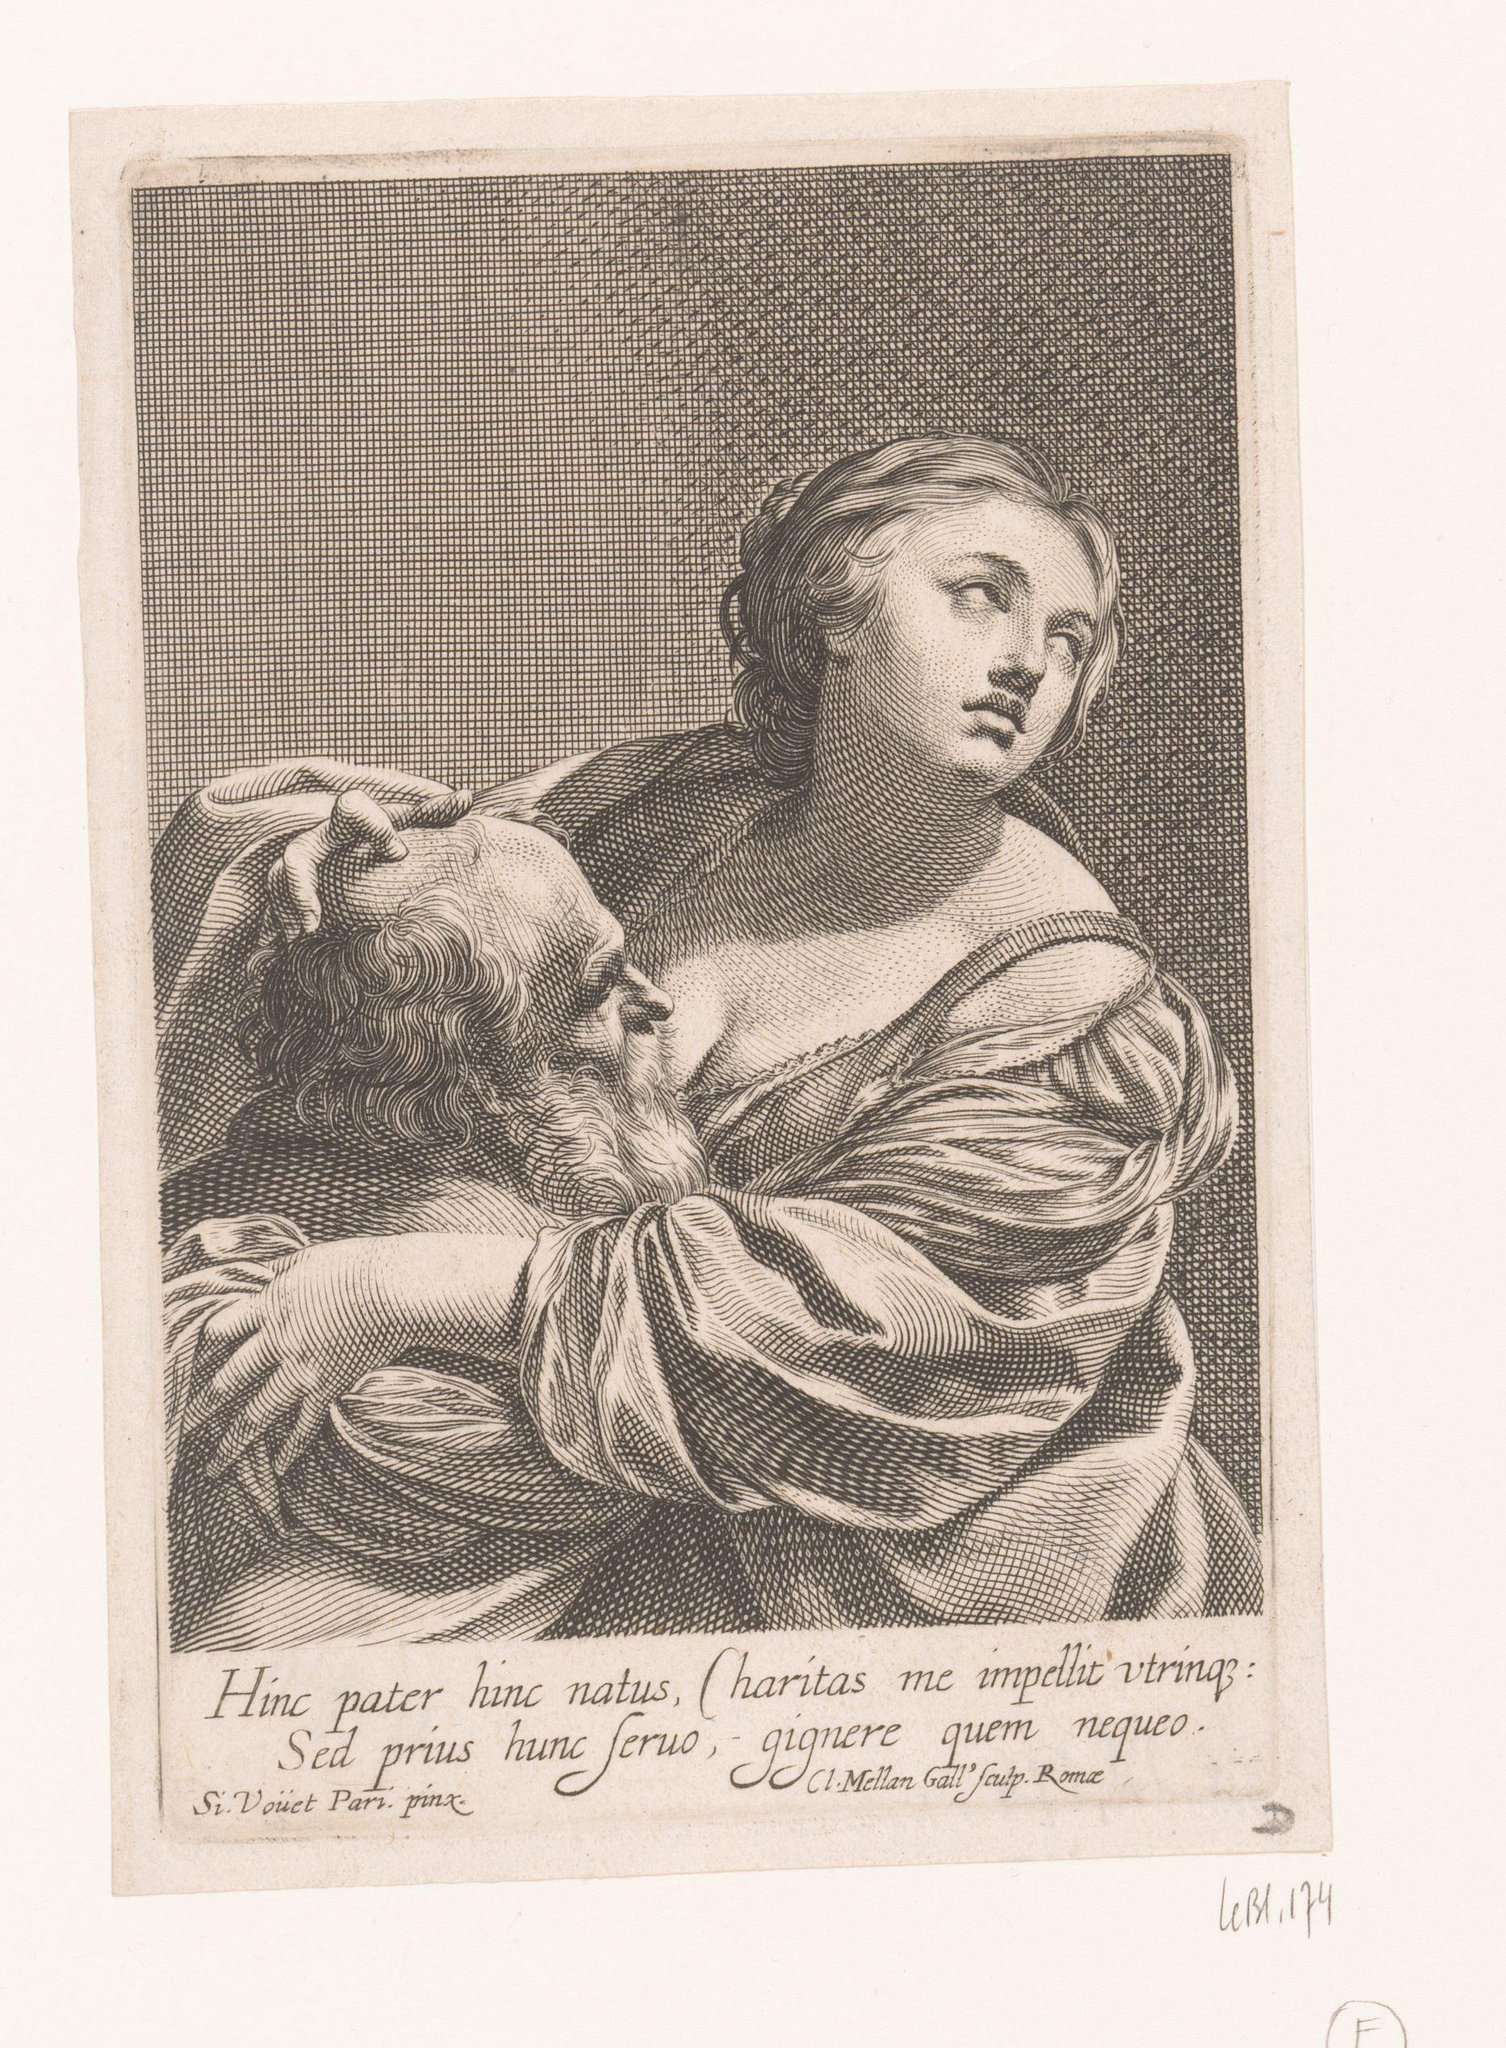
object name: print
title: Caritas Romana: Cimon voedt haar vader Pero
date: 1624-1636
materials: paper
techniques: engraving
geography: rome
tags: pero suckling cimon ('caritas romana')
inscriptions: collector's mark: Lugt 2228